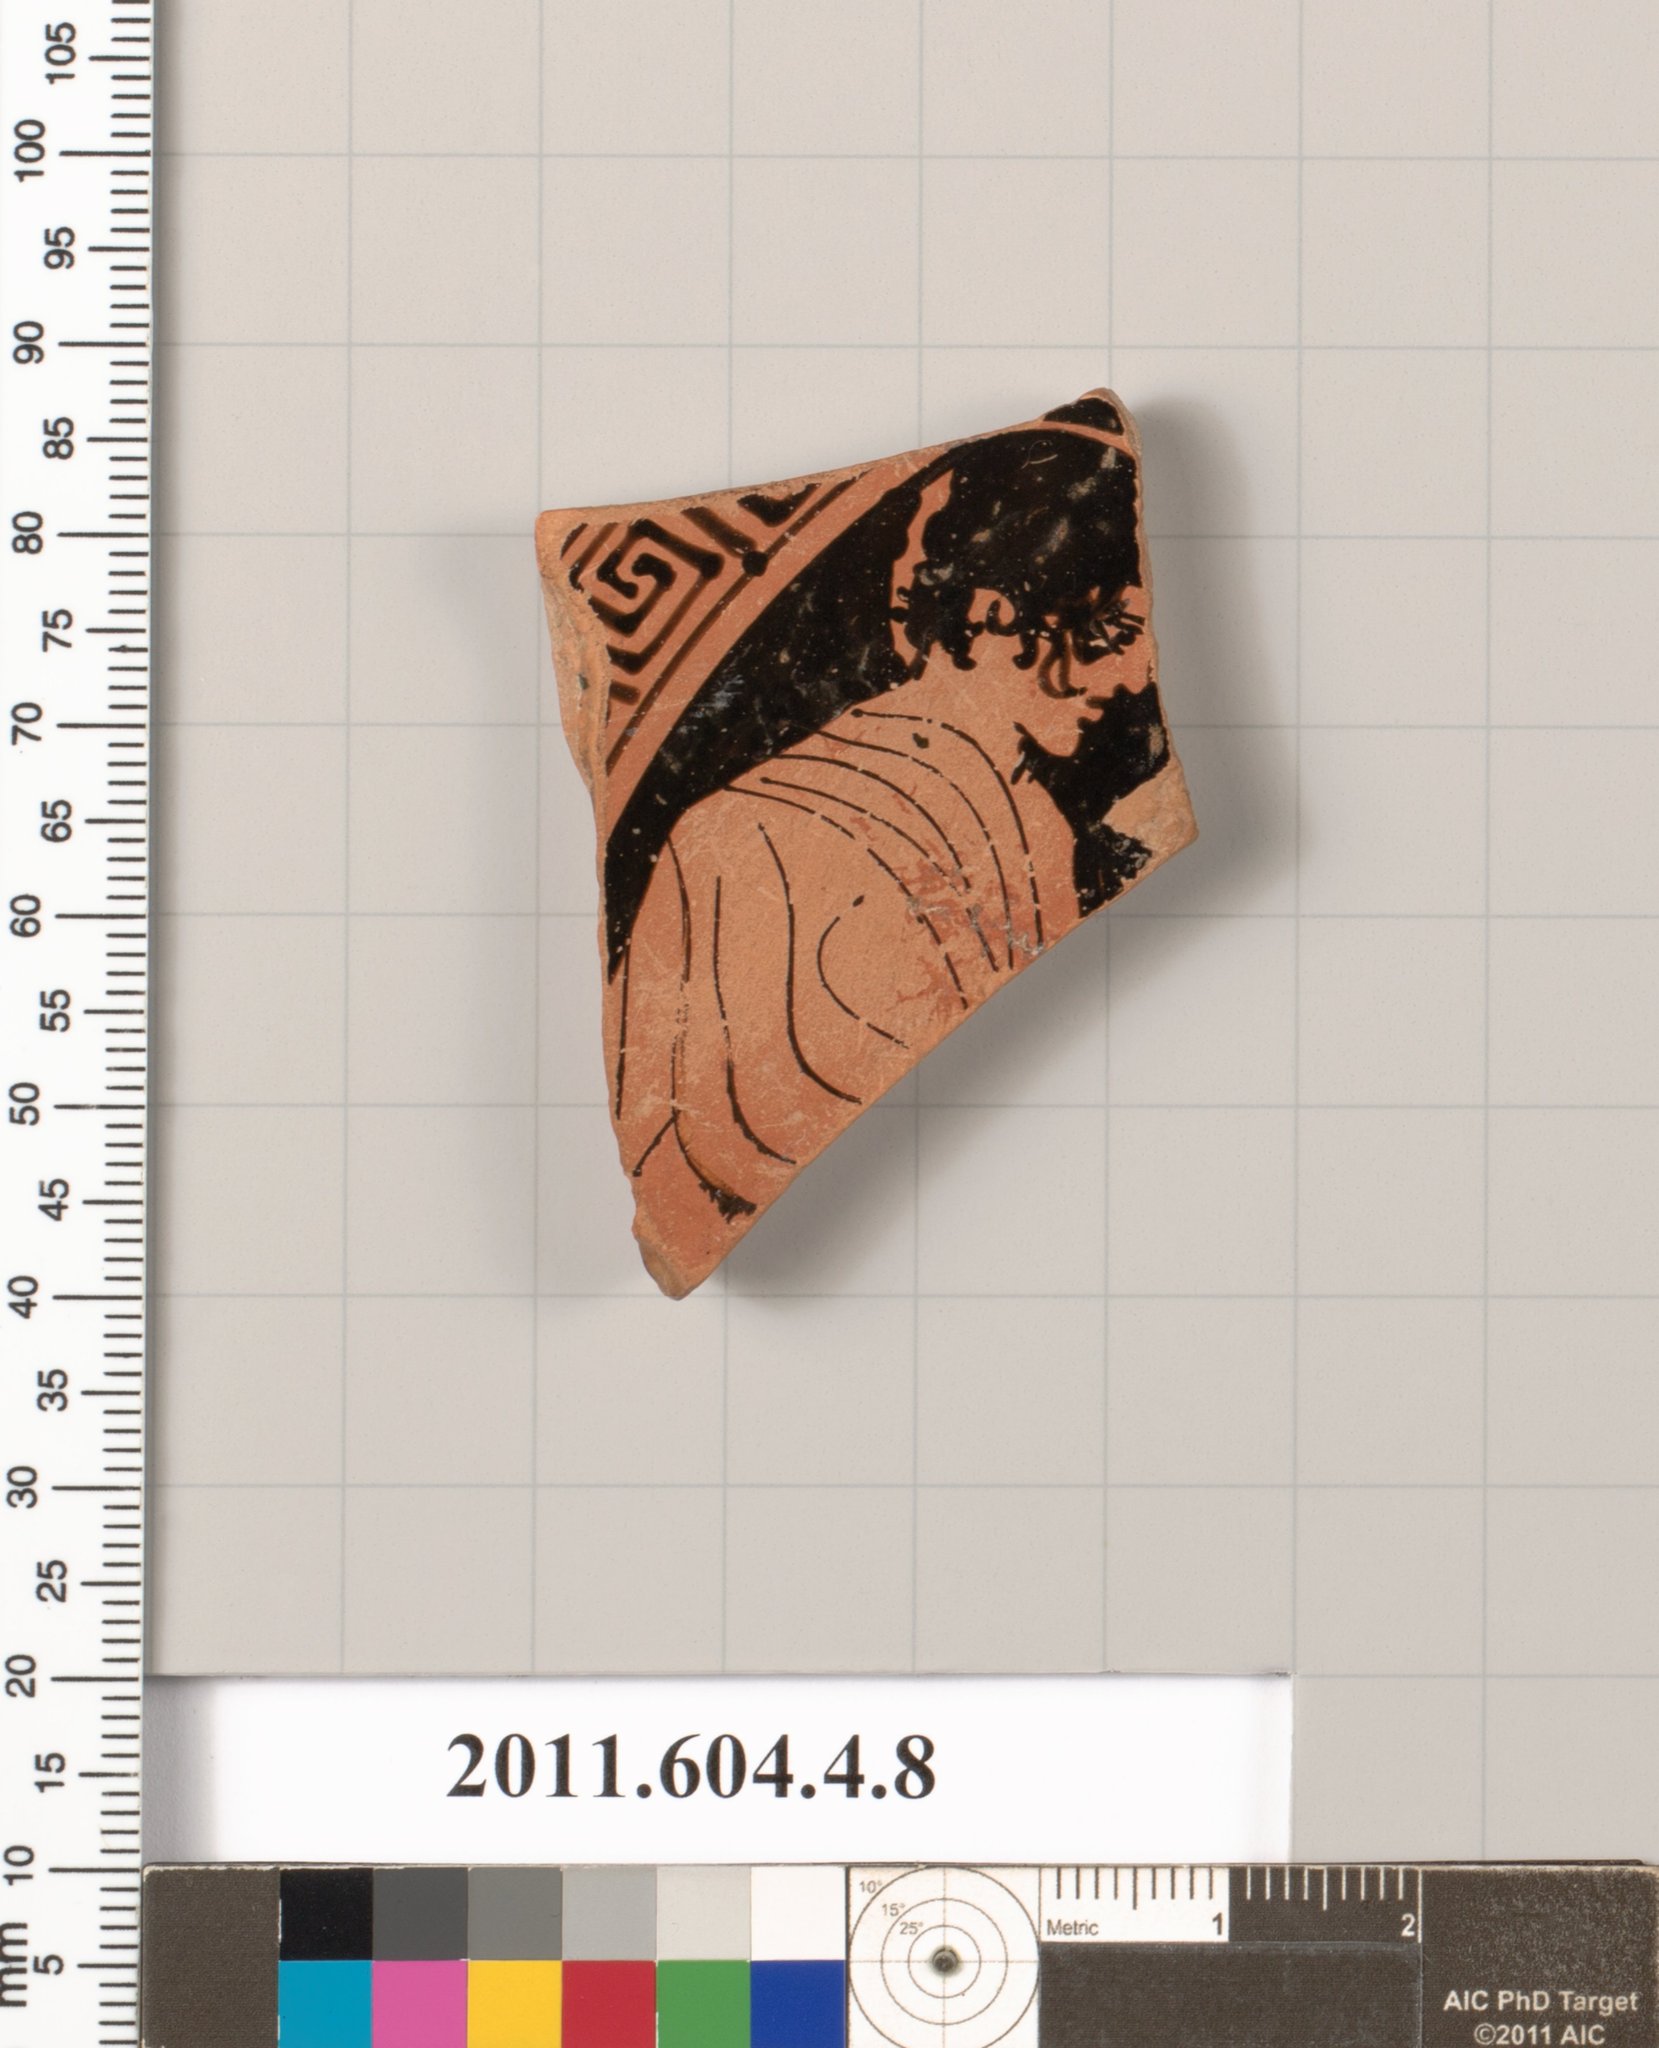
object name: kylix fragment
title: Terracotta fragment of a kylix (drinking cup)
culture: greek, attic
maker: aberdeen painter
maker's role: artist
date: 467-435 BCE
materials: terracotta